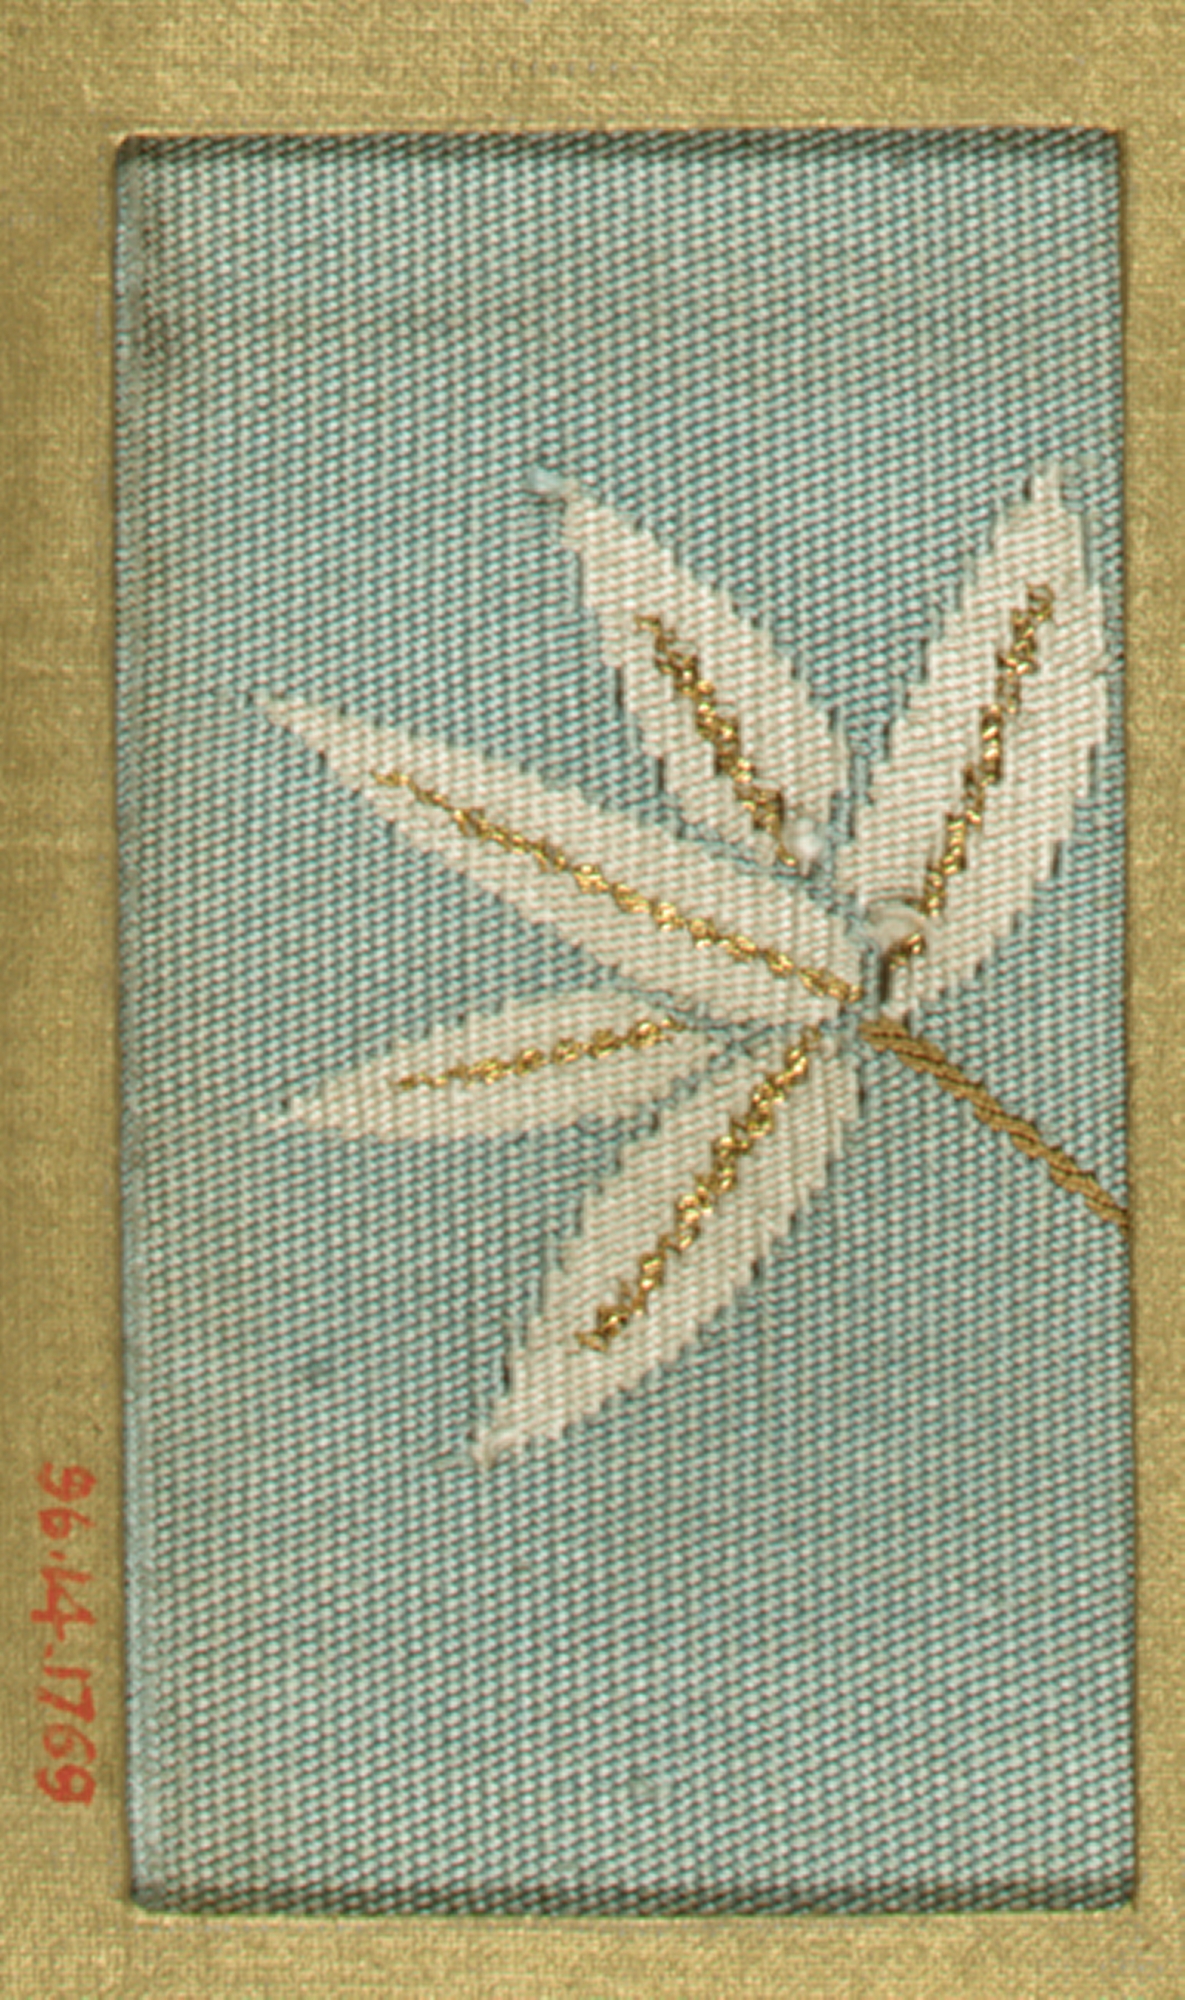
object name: piece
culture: japanese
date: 1701-1900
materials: silk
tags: leaves